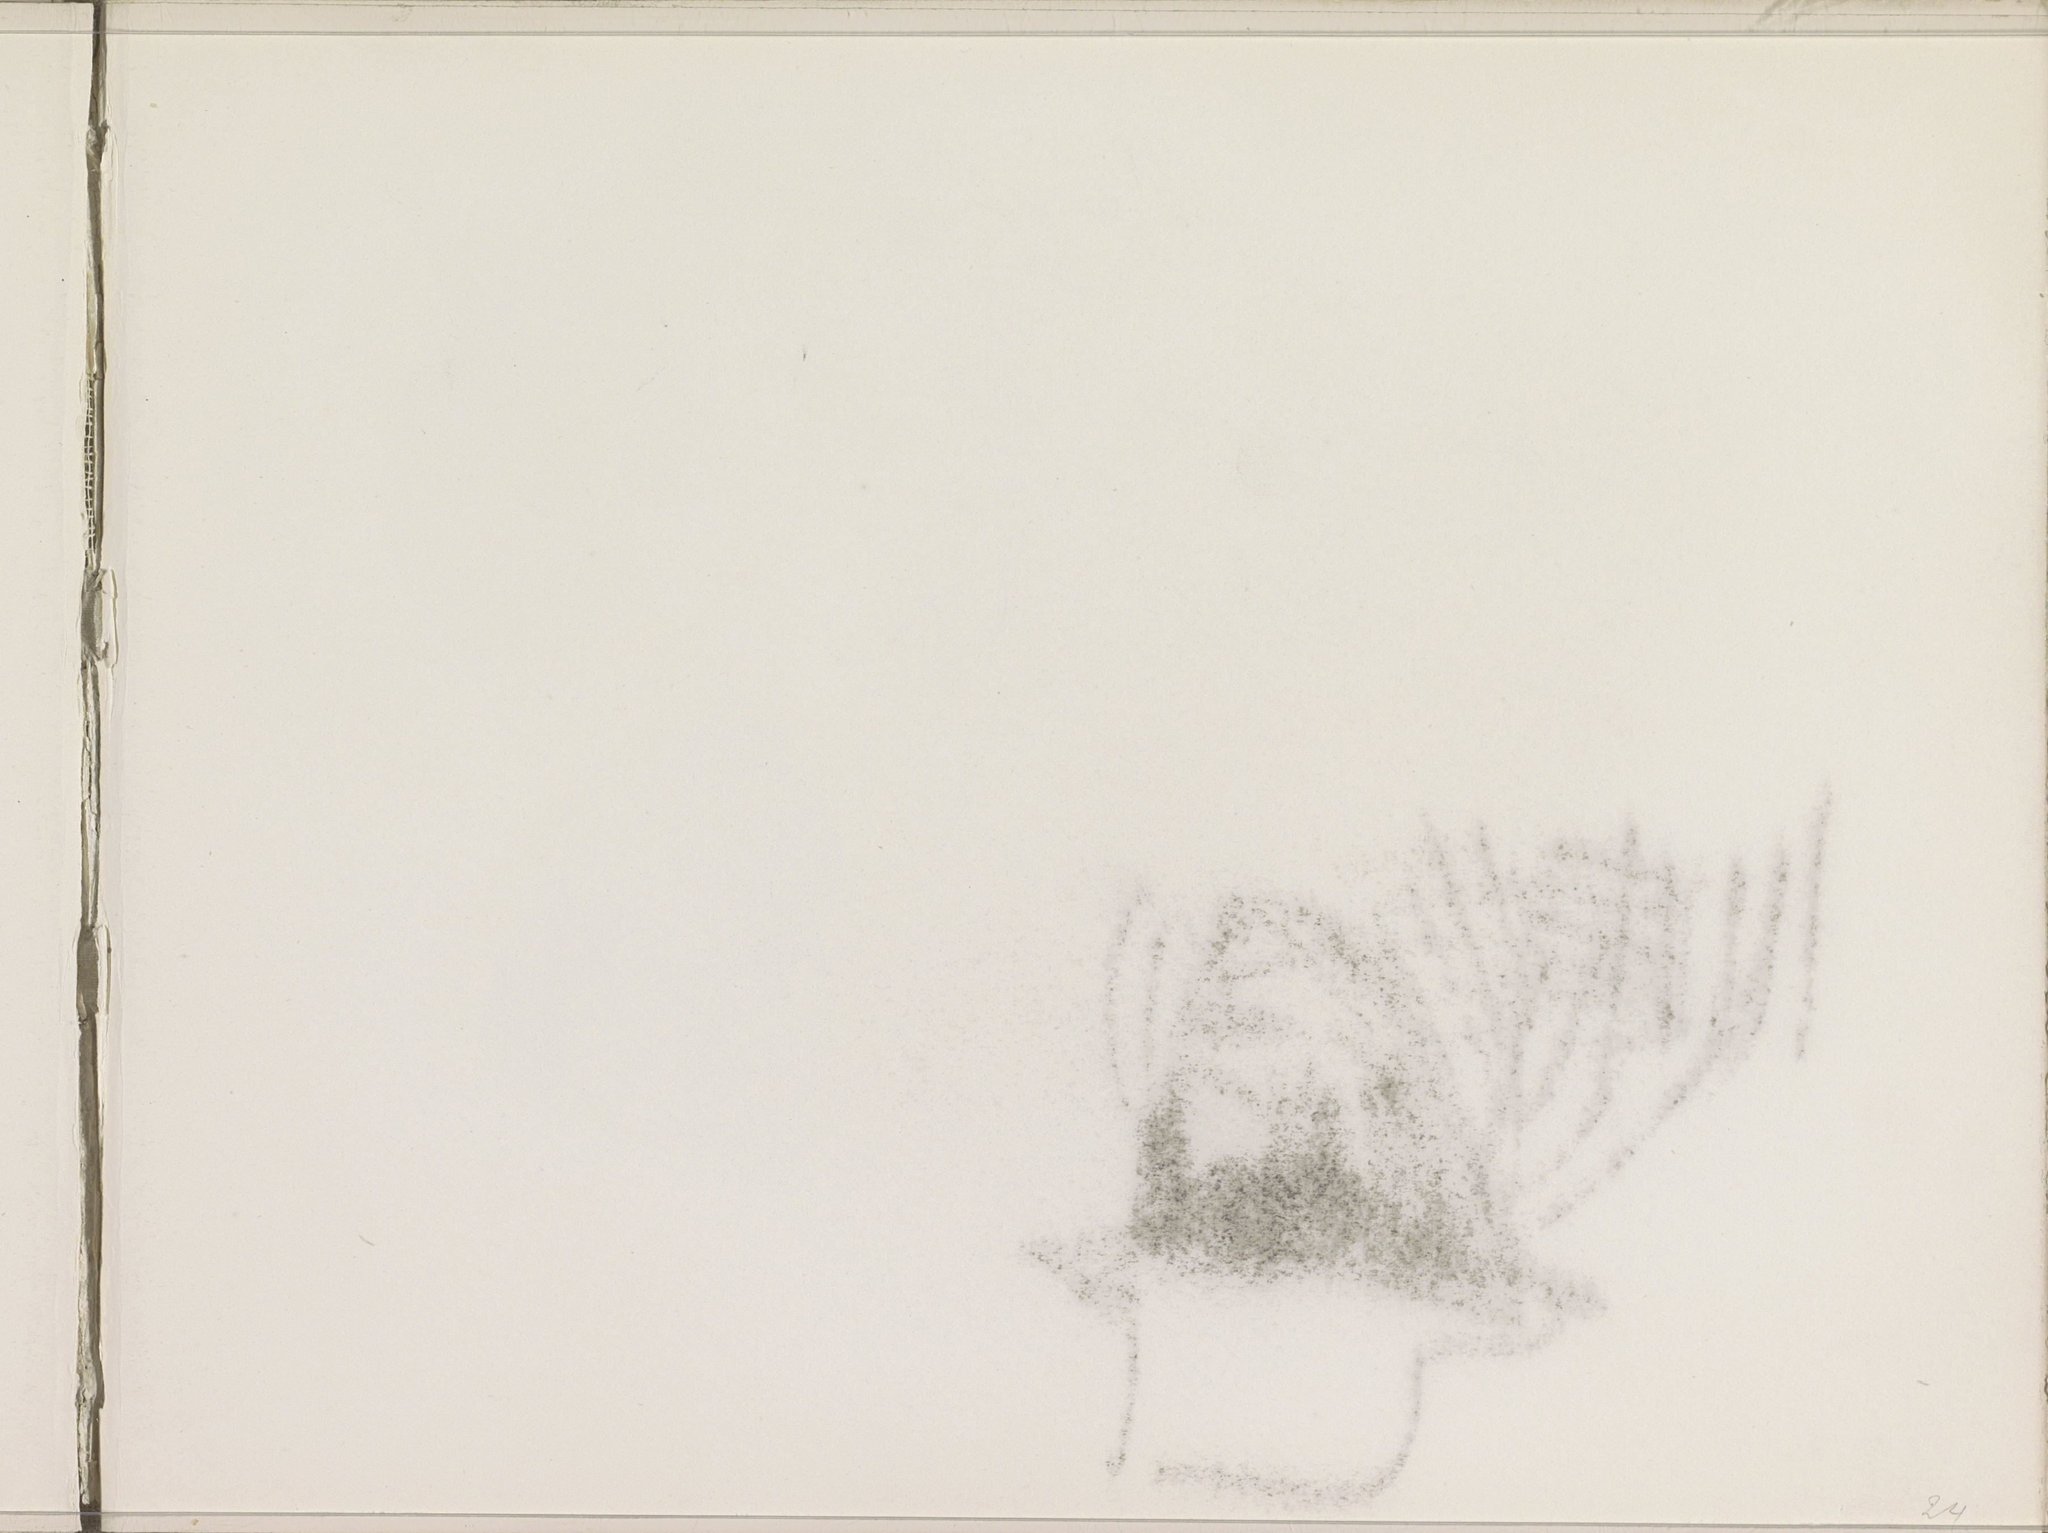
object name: sketchbook leaf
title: Abklatsch van de krijttekening op blad 23 verso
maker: isaac israels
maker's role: draughtsman, painter, print maker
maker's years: 1865-1934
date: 1875-1934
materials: paper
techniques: printmaking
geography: the hague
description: Blad 24 recto uit schetsboek VII met 26 bladen.